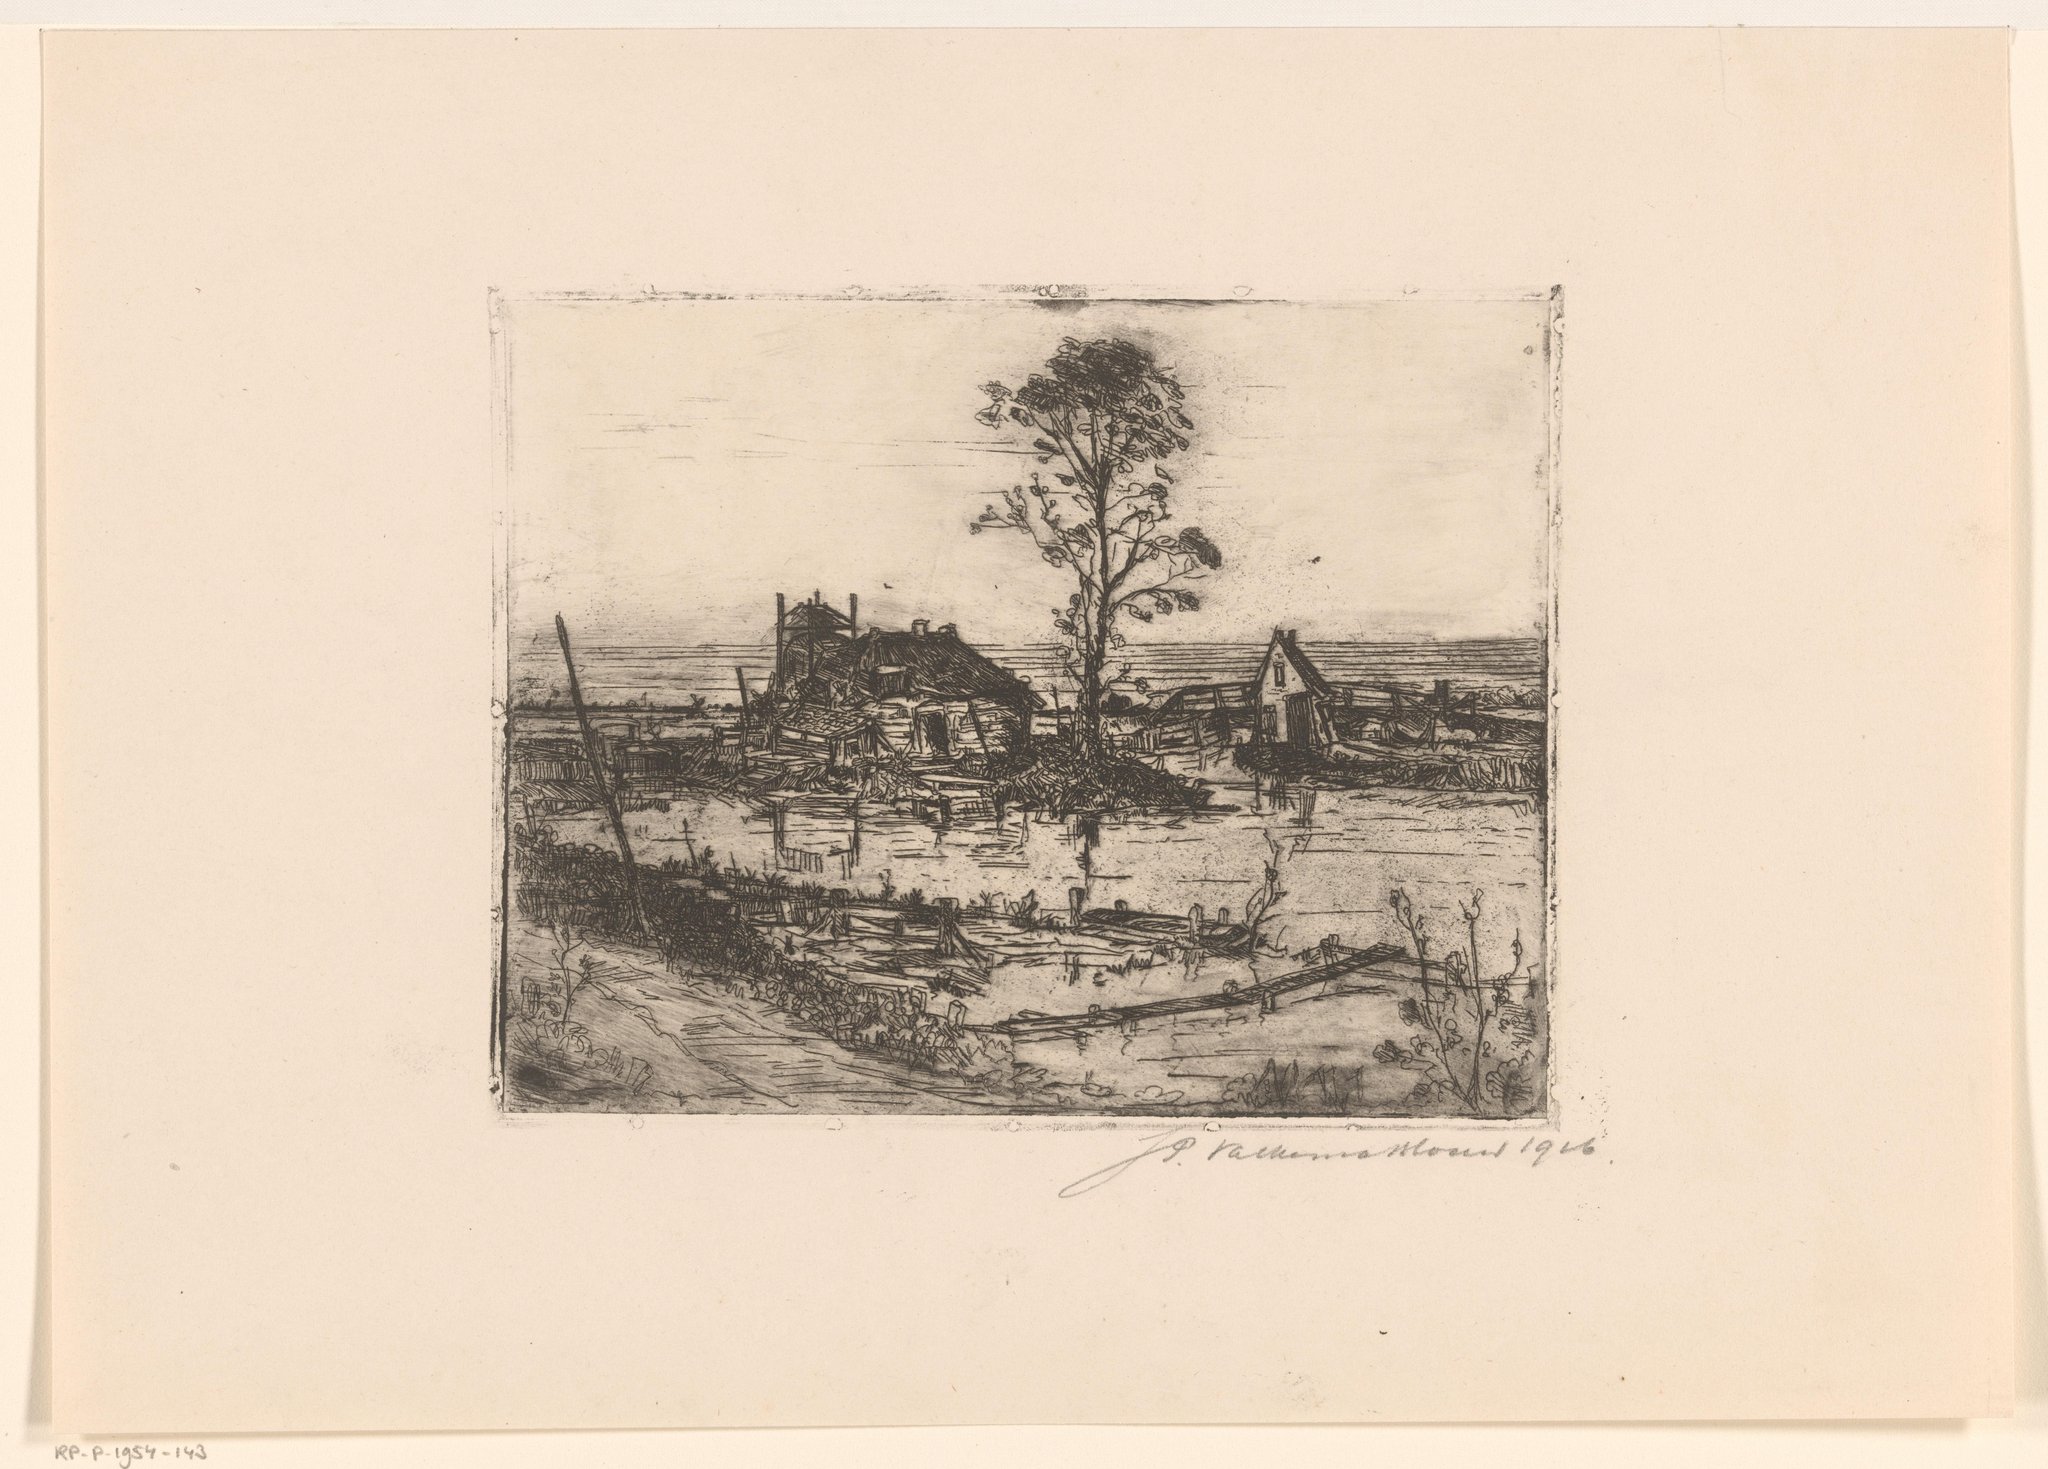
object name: print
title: Vervallen boerderij aan een plas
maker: jan paul valkema blouw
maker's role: draughtsman, print maker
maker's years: 1884-1954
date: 1916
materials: paper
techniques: etching, intaglio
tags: lake, farm or solitary house in landscape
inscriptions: collector's mark: Lugt 2760, collector's mark: Lugt 2228